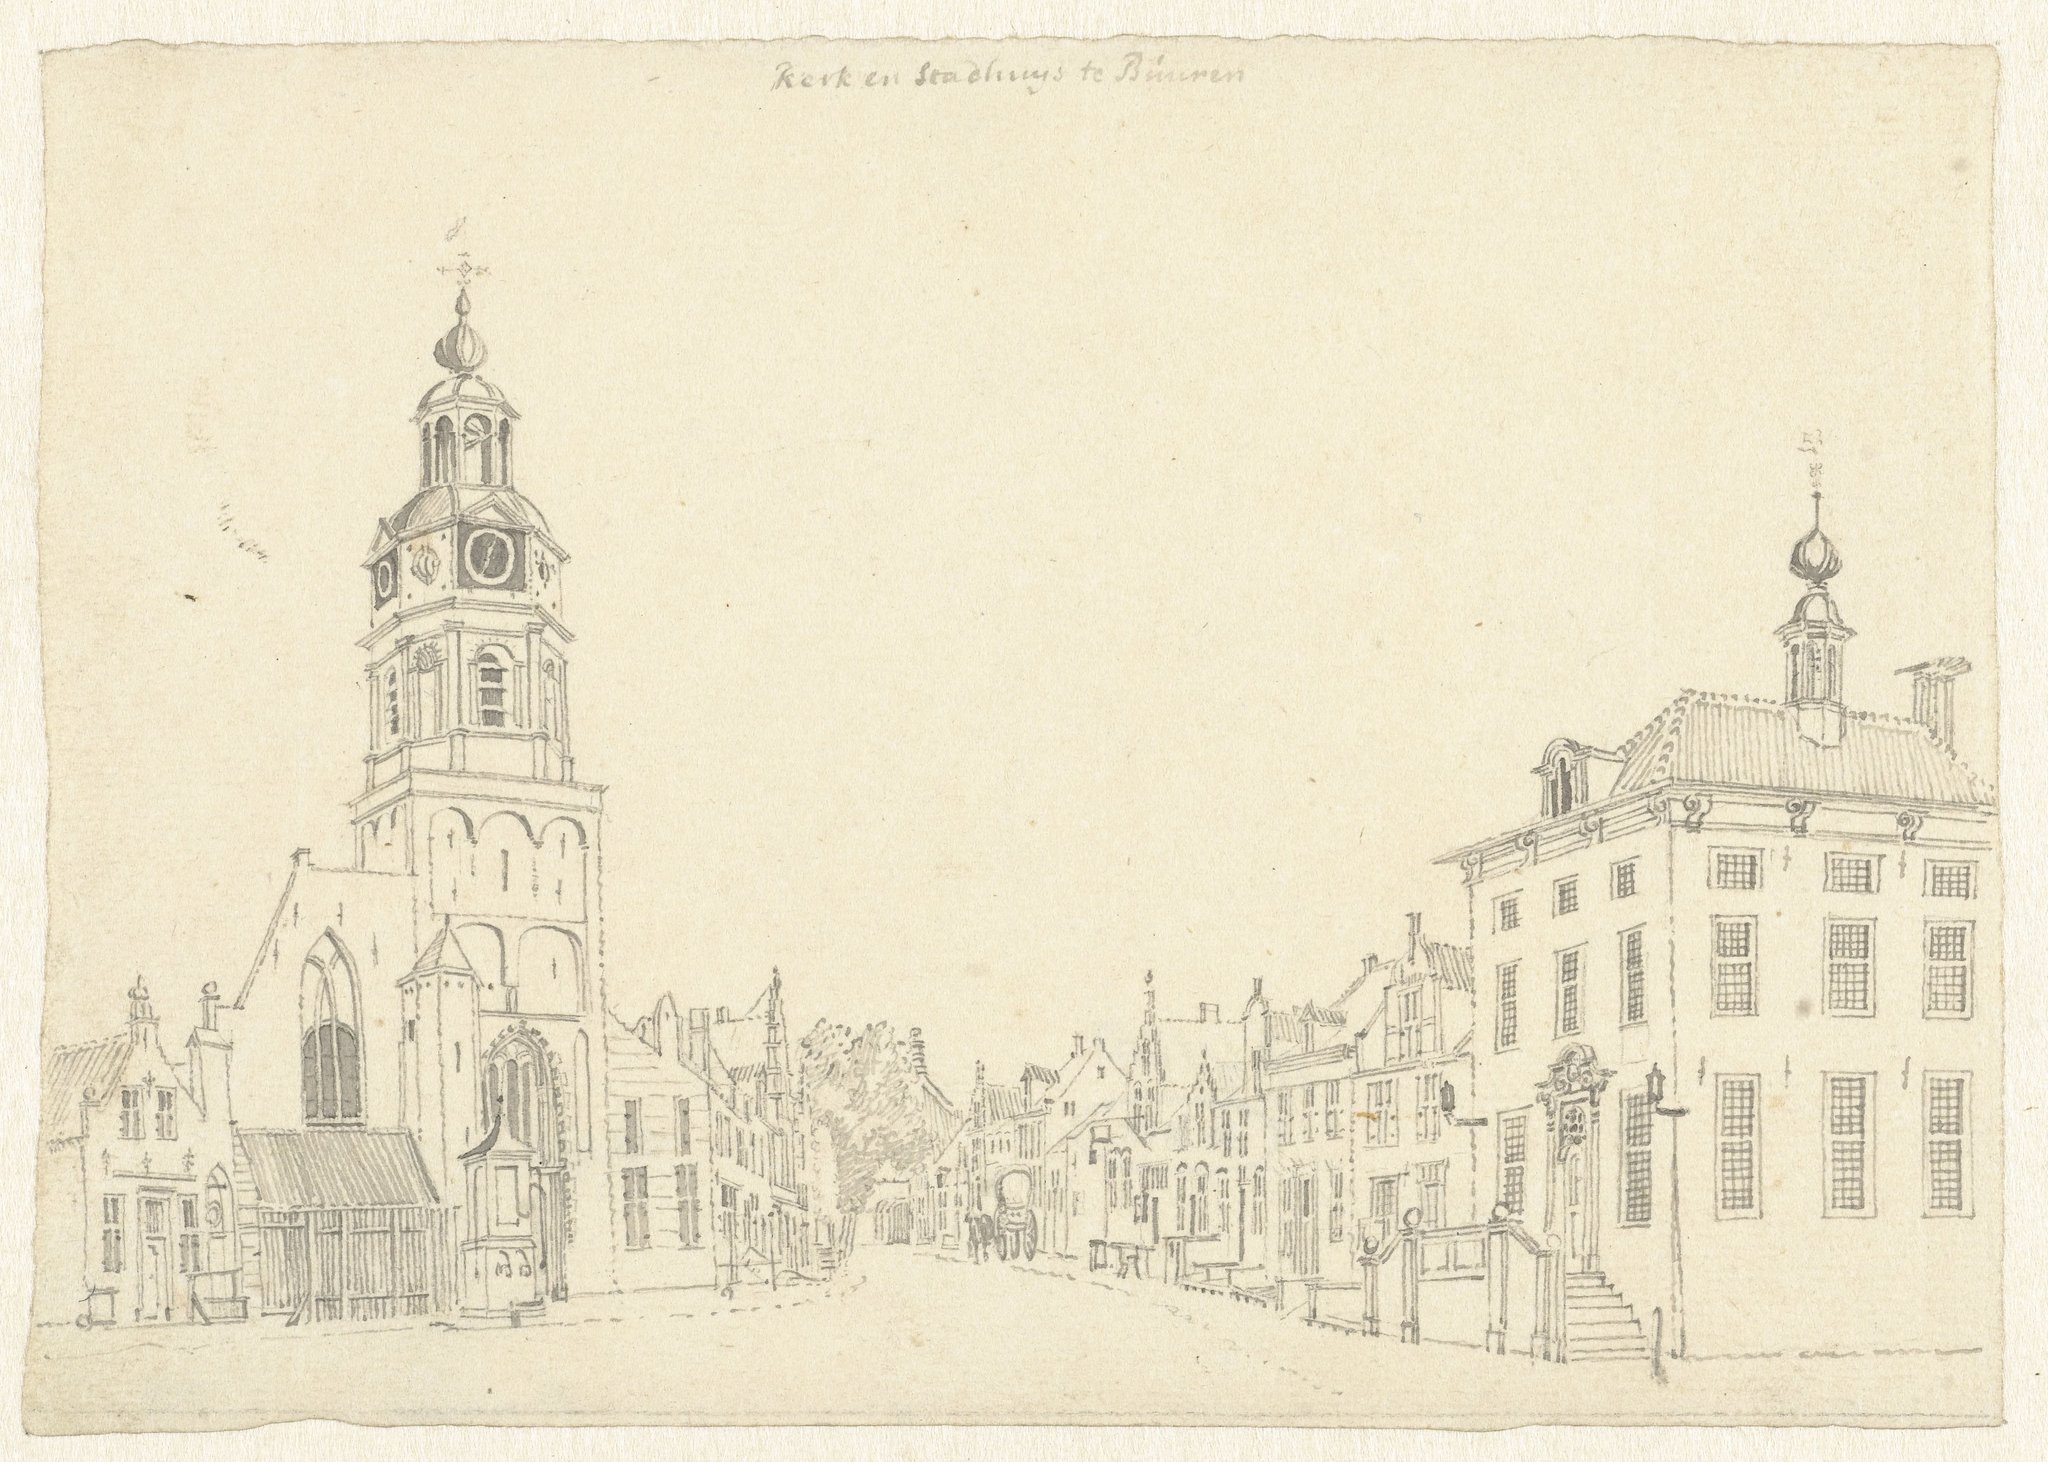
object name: drawing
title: Kerk en stadhuis te Buren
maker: jan de beijer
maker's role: draughtsman, print maker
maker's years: 1703-1780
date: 1713-1780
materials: ink, paper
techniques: brush, pen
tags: church (exterior), townhall, prospect of city, town panorama, silhouette of city, buren